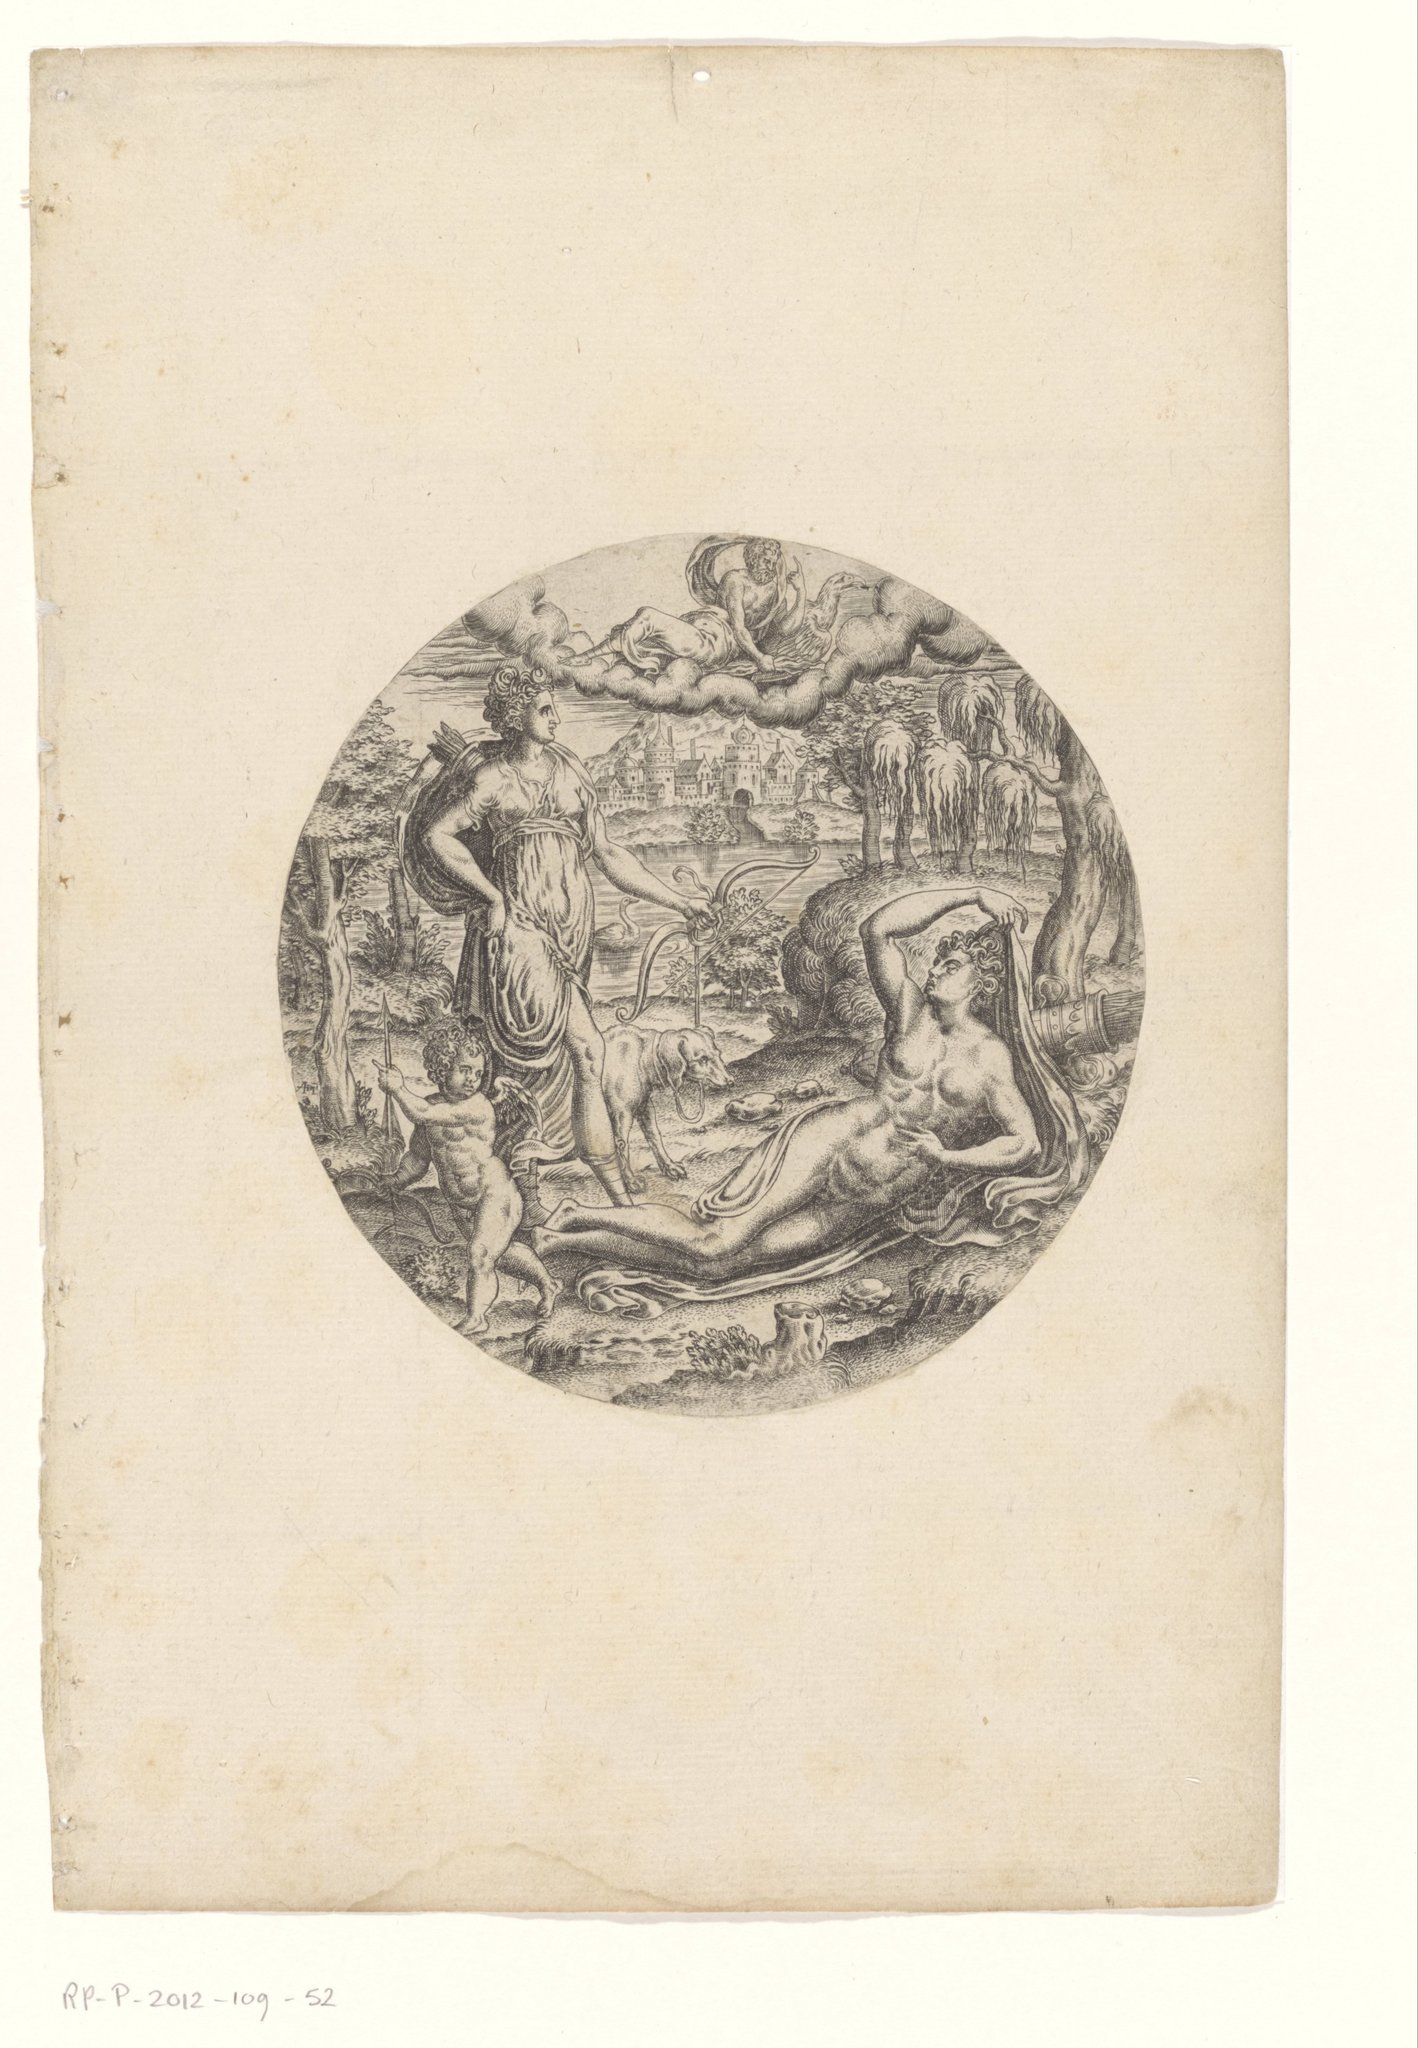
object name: print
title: Diana en Endymion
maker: abraham de bruyn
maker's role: print maker, publisher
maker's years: 1540-1587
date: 1550-1587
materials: paper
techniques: etching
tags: diana (luna) visiting the sleeping endymion